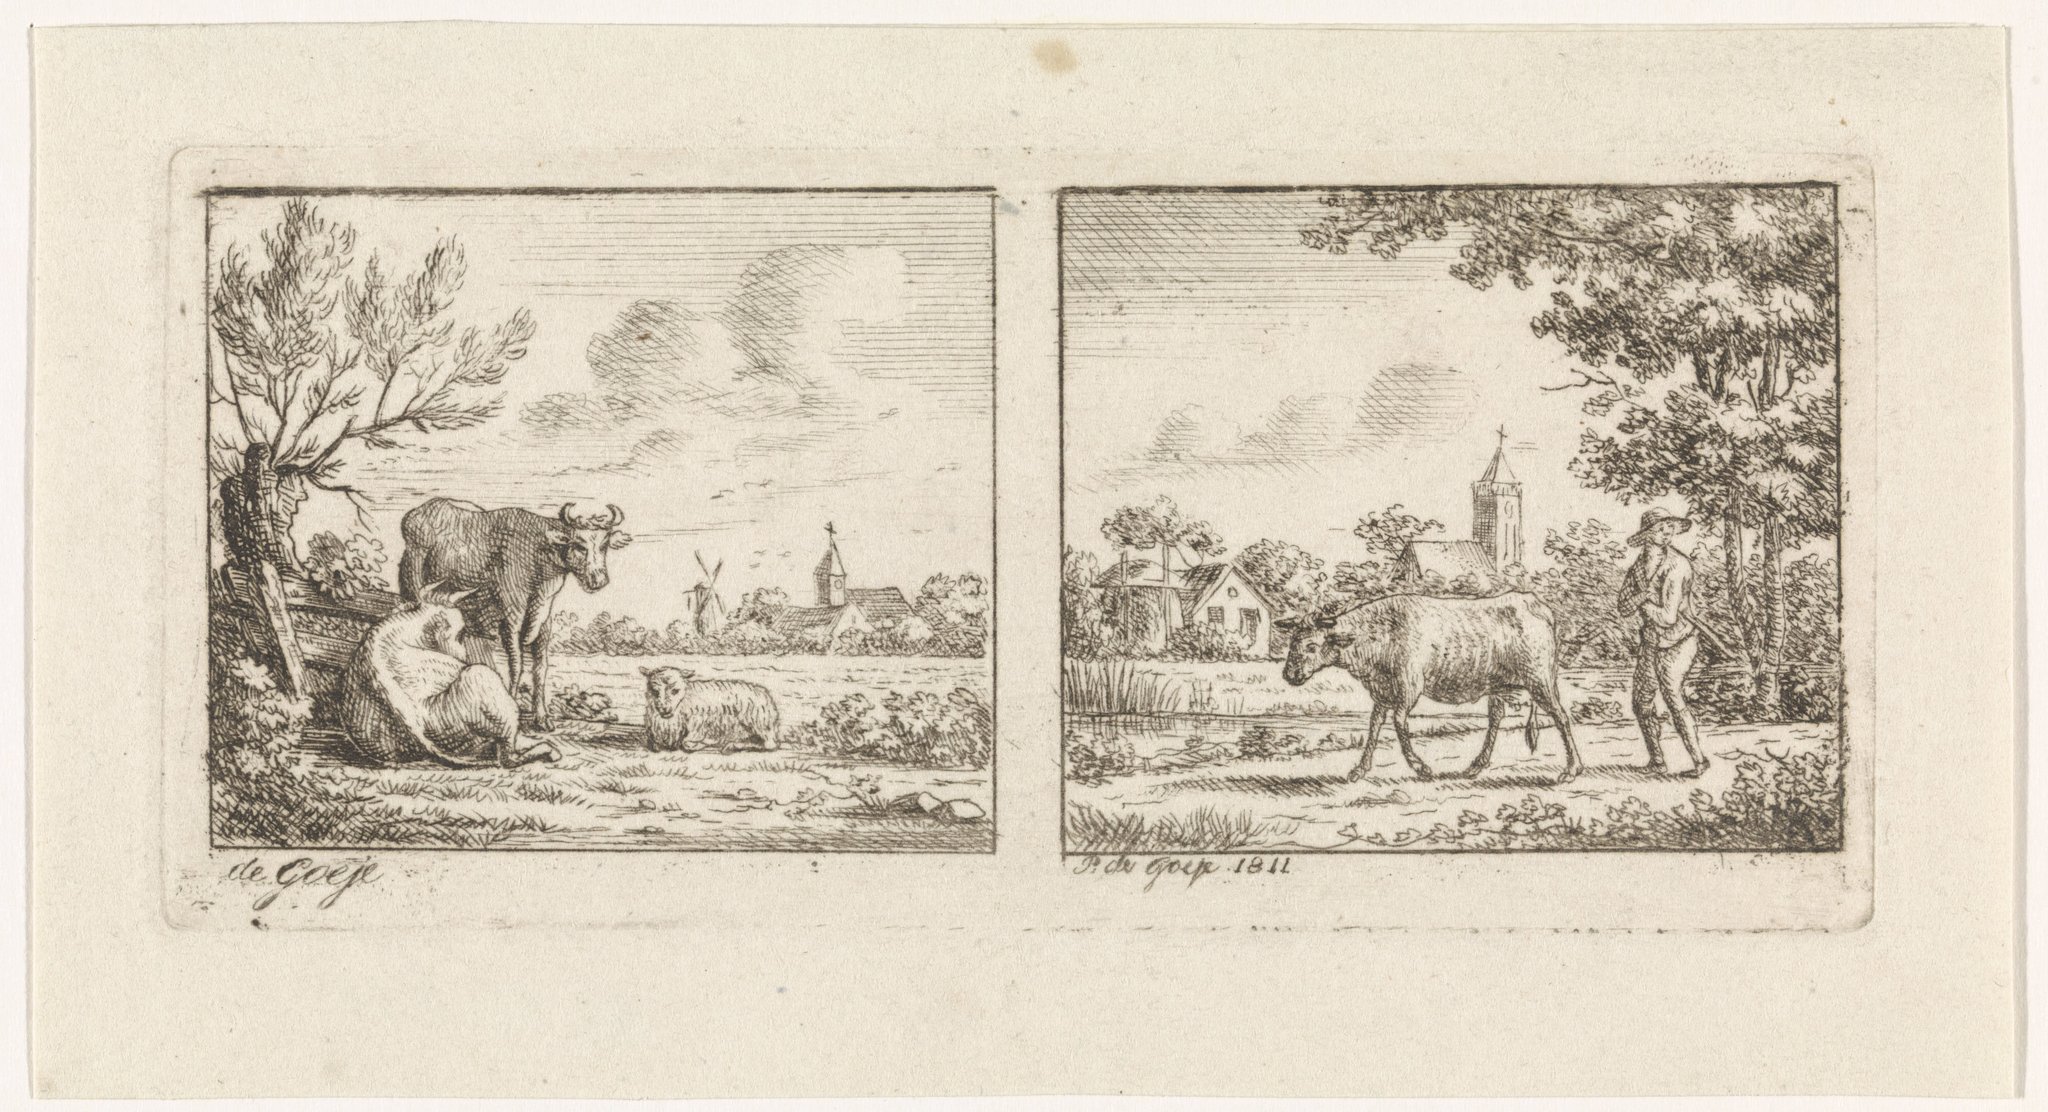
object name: print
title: Klassieke ruïne met een paartje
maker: abraham genoels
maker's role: draughtsman, print maker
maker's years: 1640-1723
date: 1650-1723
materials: paper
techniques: etching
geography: rome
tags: temple, shrine ~ roman religion, landscape with ruins (+ city(-scape) with figures, staffage)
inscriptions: collector's mark: Lugt 240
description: Een zittende man praat met een staande vrouw nabij de ruïne van een klassieke tempel.